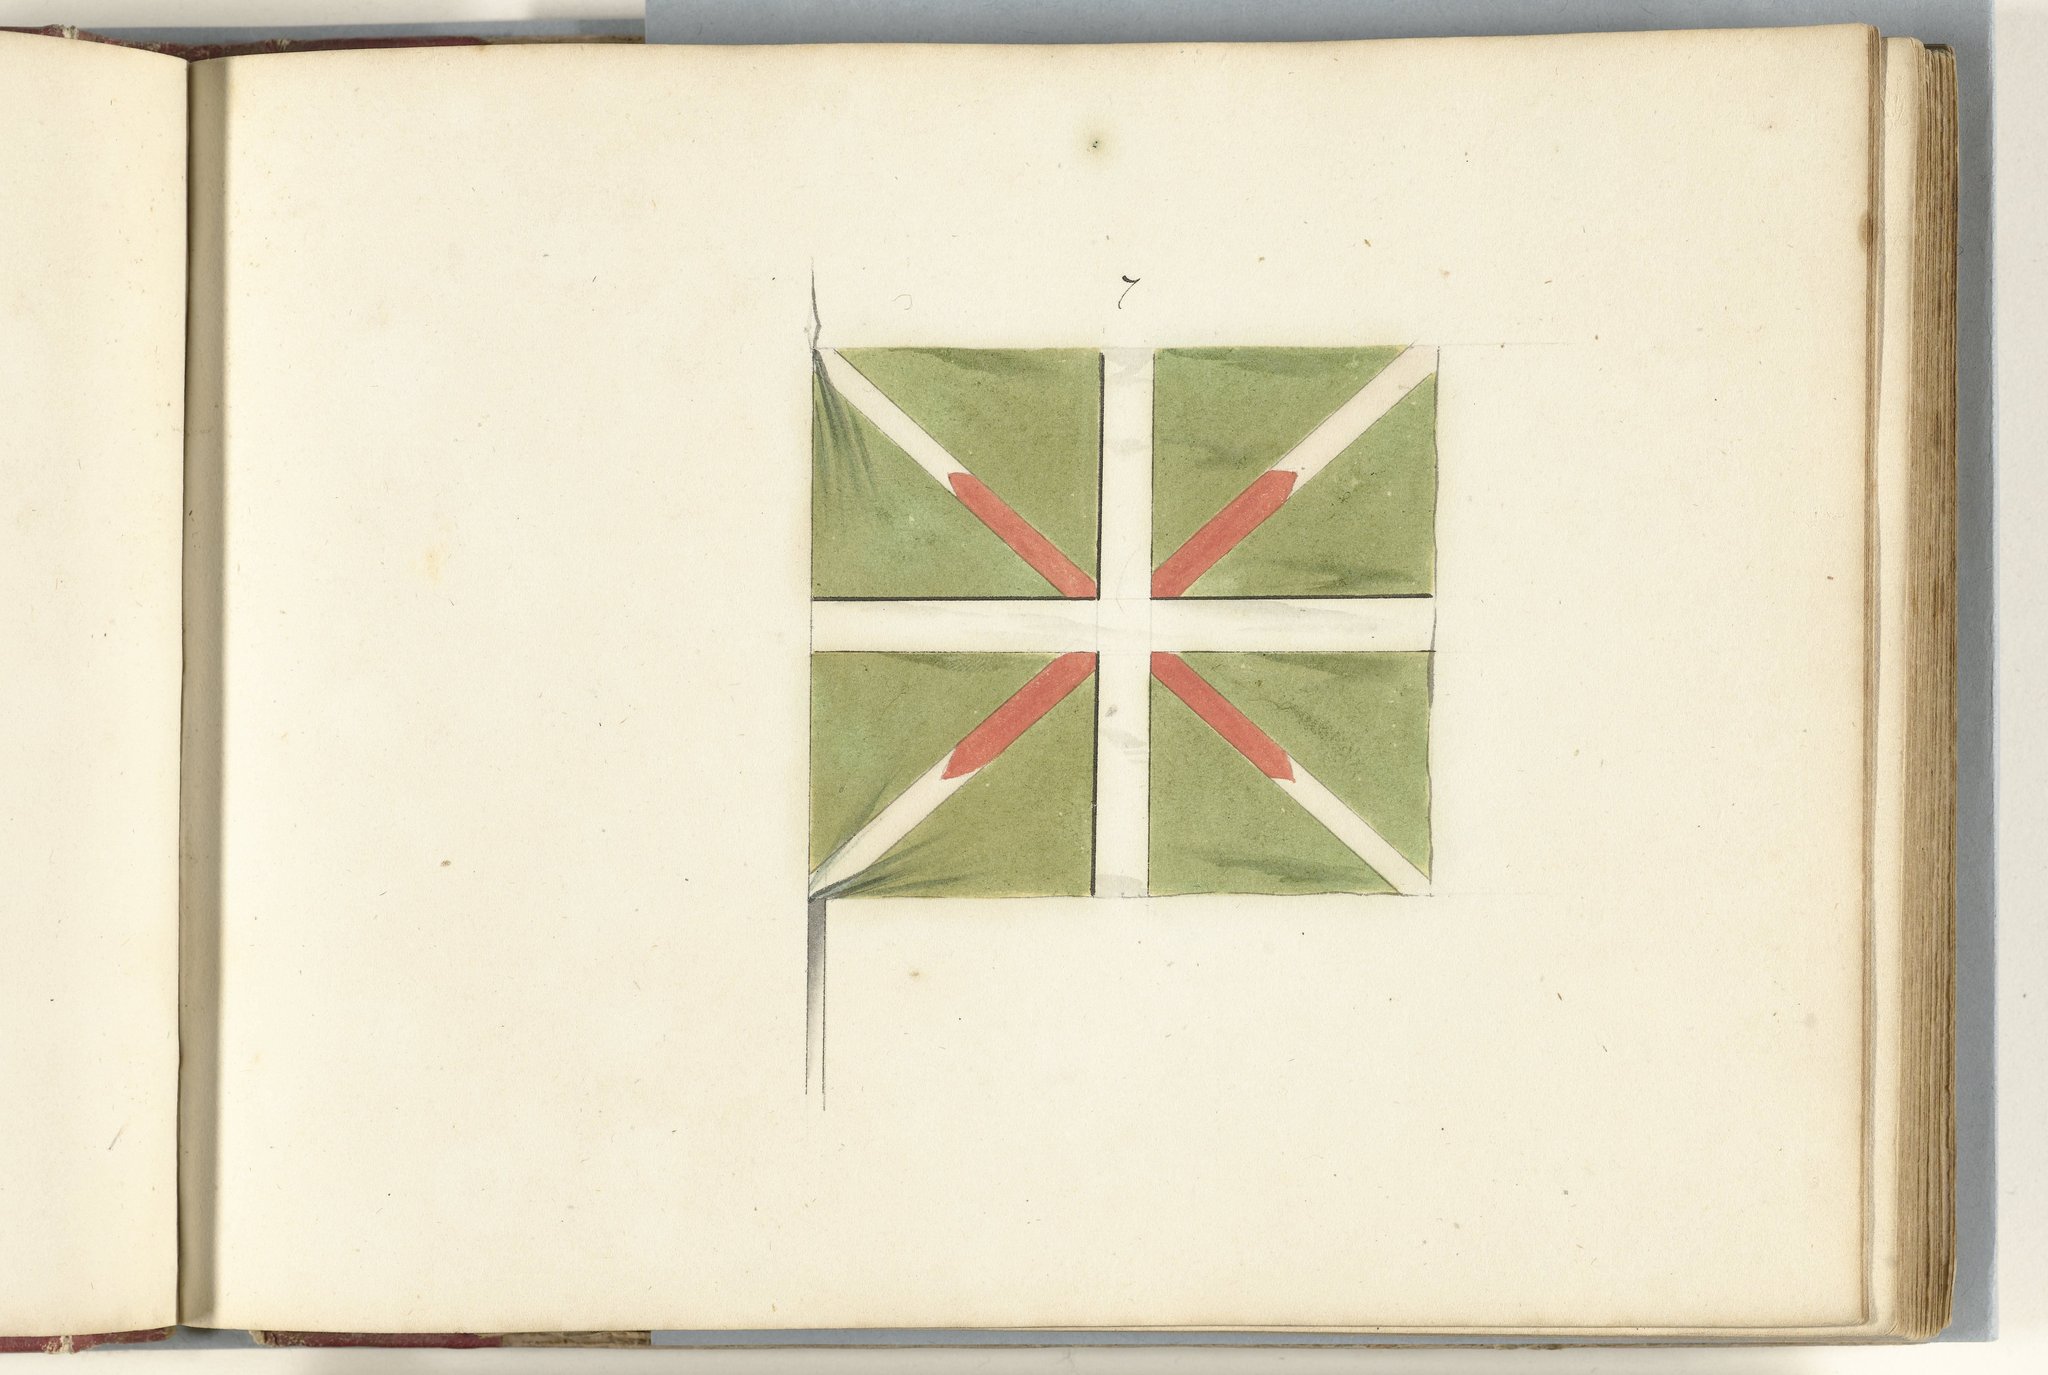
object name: drawing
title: Frans vaandel veroverd bij Dendermonde, 1706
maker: Anonymous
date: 1713-1720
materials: paper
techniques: drawing, writing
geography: northern netherlands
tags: (military) flags and standards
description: Frans vaandel veroverd bij Dendermonde in 1706. In het boek met tekeningen van Franse vaandels, standaarden en pauken, veroverd tijdens de Spaanse Successieoorlog (1701-1713).